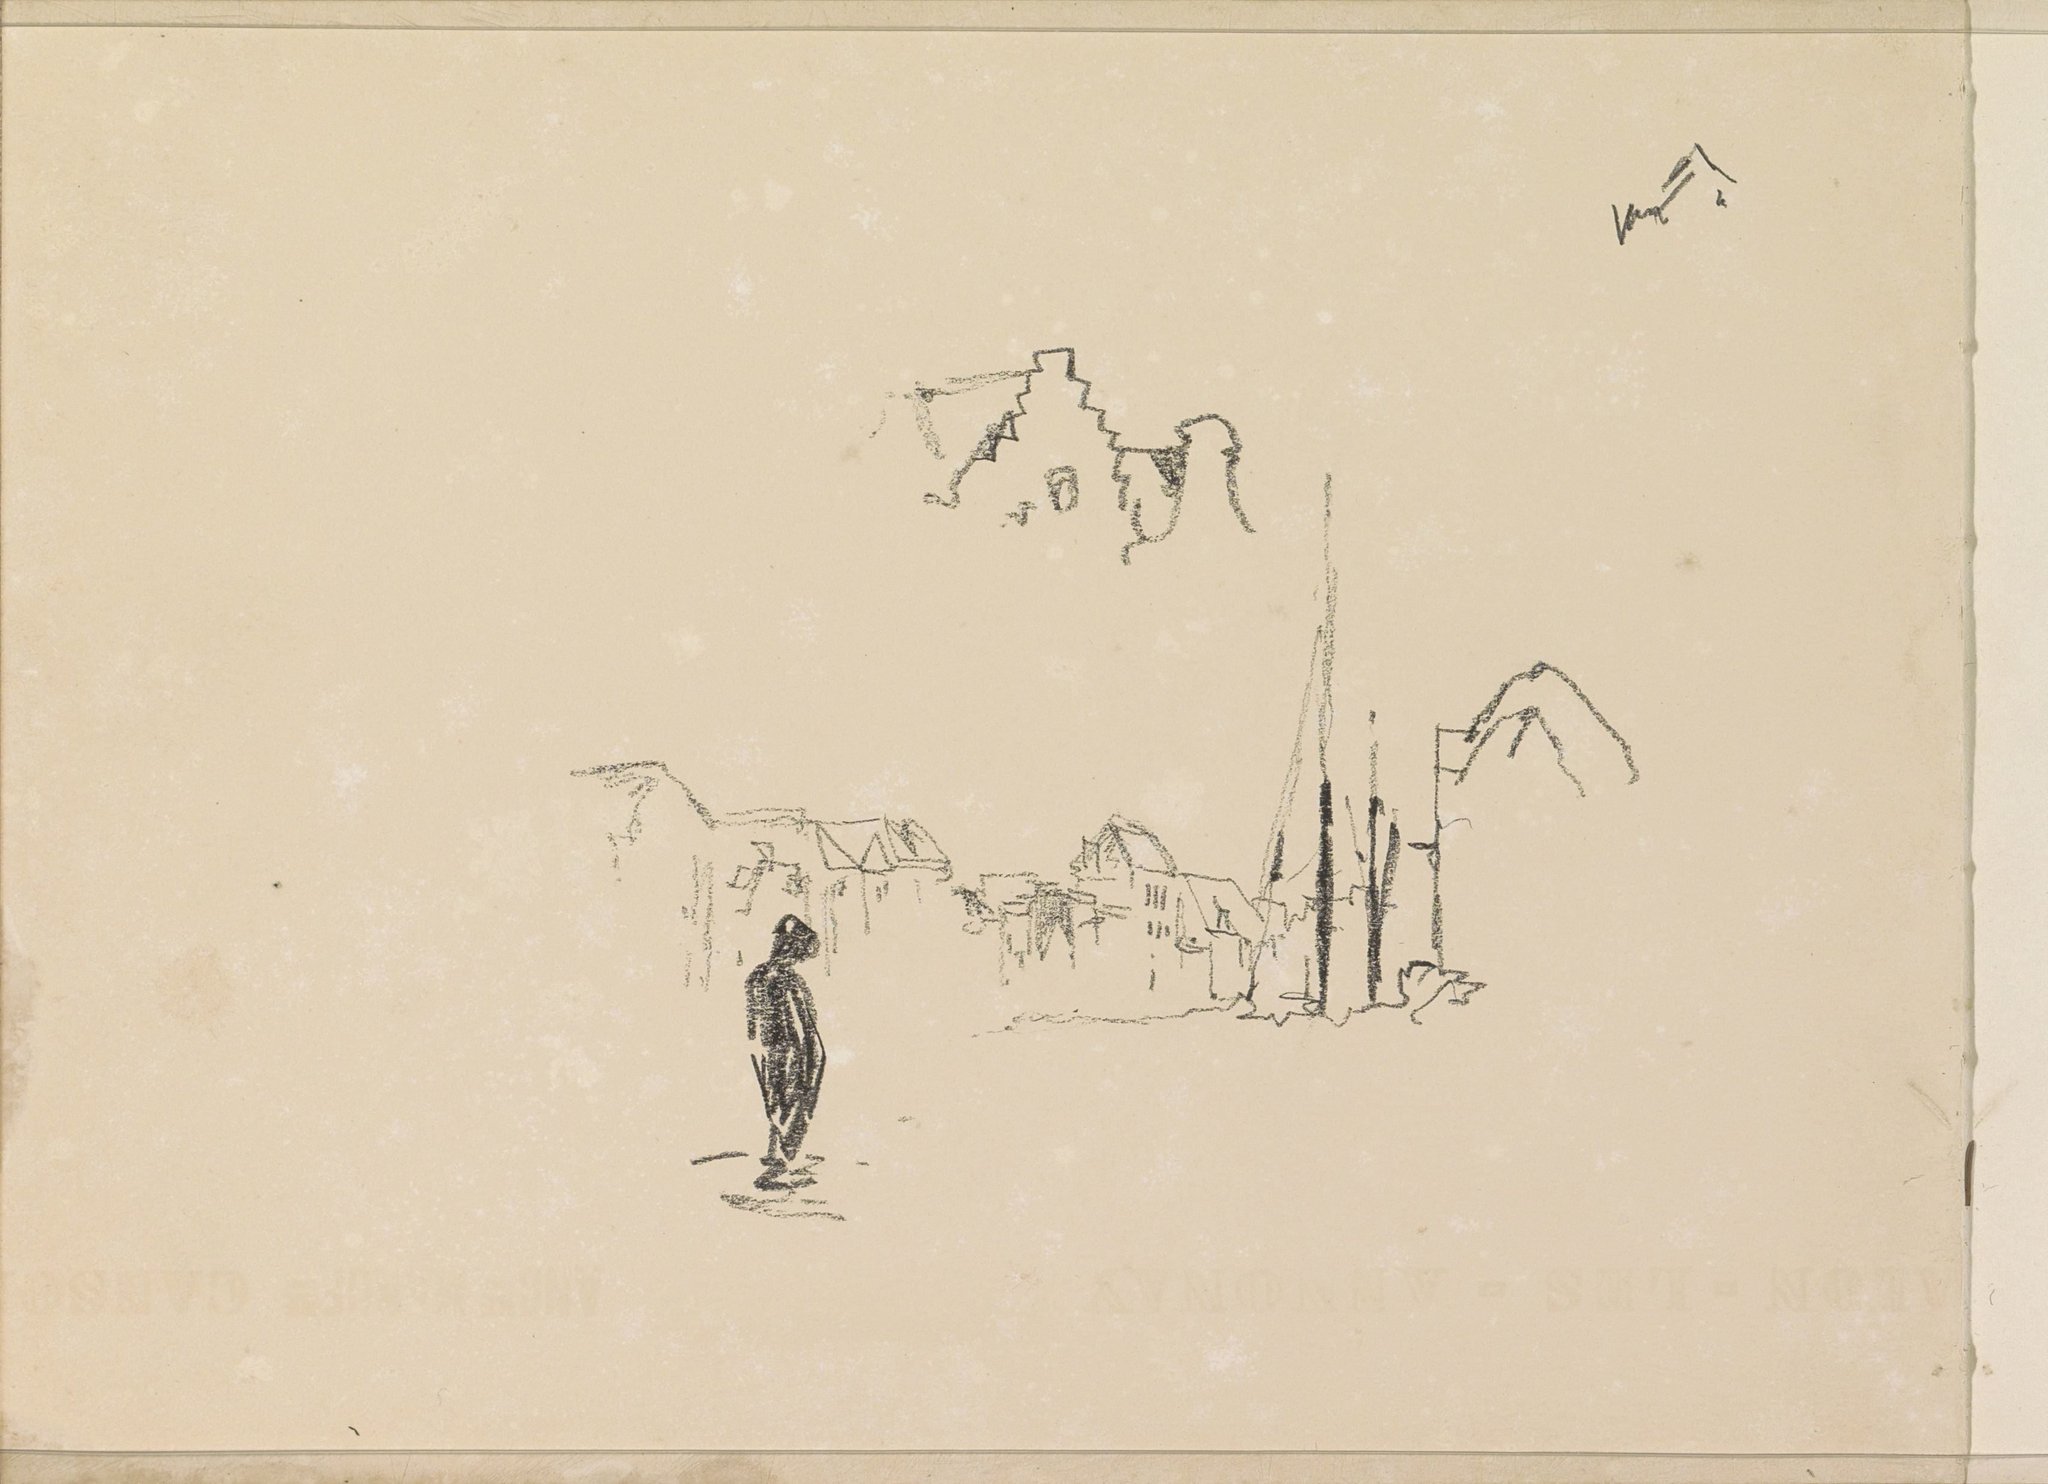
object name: sketchbook leaf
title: Figuur op een straat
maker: cornelis vreedenburgh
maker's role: draughtsman, print maker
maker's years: 1880-1946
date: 1890-1946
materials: chalk, paper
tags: parts of ship's exterior: mast, street (+ city(-scape) with figures, staffage)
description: Op de achtergrond de masten van zeilschepen. Tevens studies van een klok- en trapgevel. Blad 5 verso uit een schetsboek met 24 bladen.